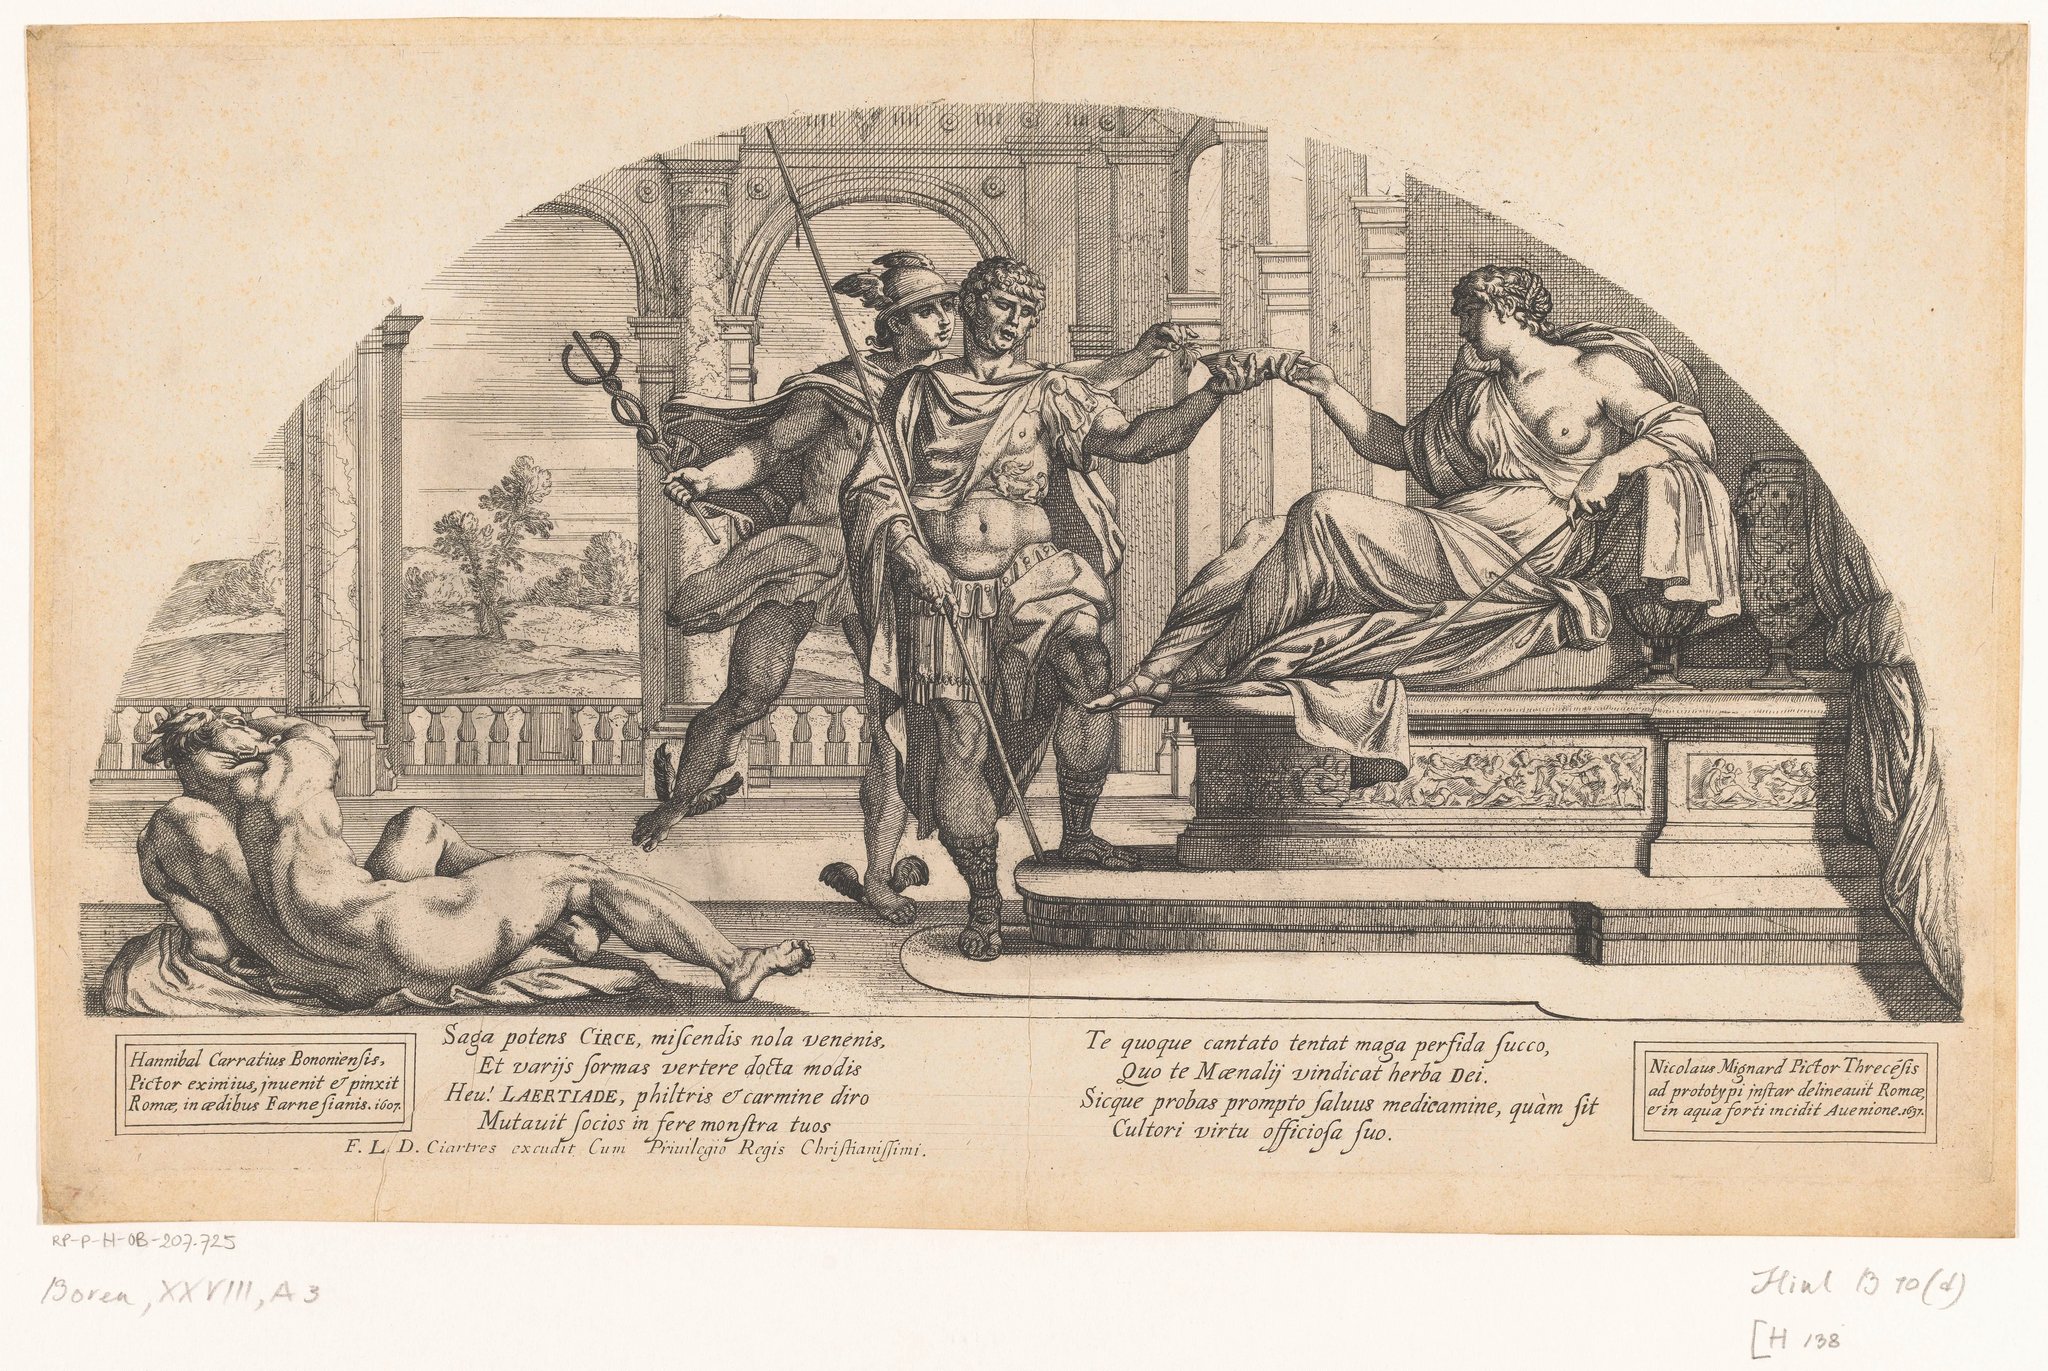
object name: print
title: Odysseus en Mercurius voor Circe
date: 1637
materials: paper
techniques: etching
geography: rome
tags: mercury gives ulysses the magic herb 'moly', a countercharm, ulysses' companions changed into swine: when they drink from the cup offered by circe, the enchantress, ulysses' companions change into swine (ovid, metamorphoses xiv 276)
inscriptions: collector's mark: ‘Hinloopen’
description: Naar een fresco door Annibale Carracci in de Camerino Farnese in het Palazzo Farnese te Rome. Deze prent maakte oorspronkelijk deel uit van liber nr. 22 van de Atlas van Rome, uit de collectie Hinloopen. In dit album waren een aantal prentreeksen naar bekende zeventiende eeuwse frescoseries bijeengebonden. In 1709 heeft Schijnvoet op last van de burgemeesters van Amsterdam de collectie herordend. De prenten uit liber 22 kwamen terrecht in Schijnvoet boek nr. 10. De laatst gedateerde reeks in het album is gedateerd 1691. Het album moet dus na deze datum gebonden zijn. De band is in de Rijksakademietijd uit elkaar gehaald. De marges van de prenten zijn bij het opbergen in het Rijksprentenkabinet vaak drastisch afgesneden. Van een aantal series waren de prenten teruggeslagen om in het album te passen. (Zie: Waals, Jan van der. De prentschat van Michiel Hinloopen. 's-Gravenhage: SDU uitgeverij, 1988, pp. 173-174.)